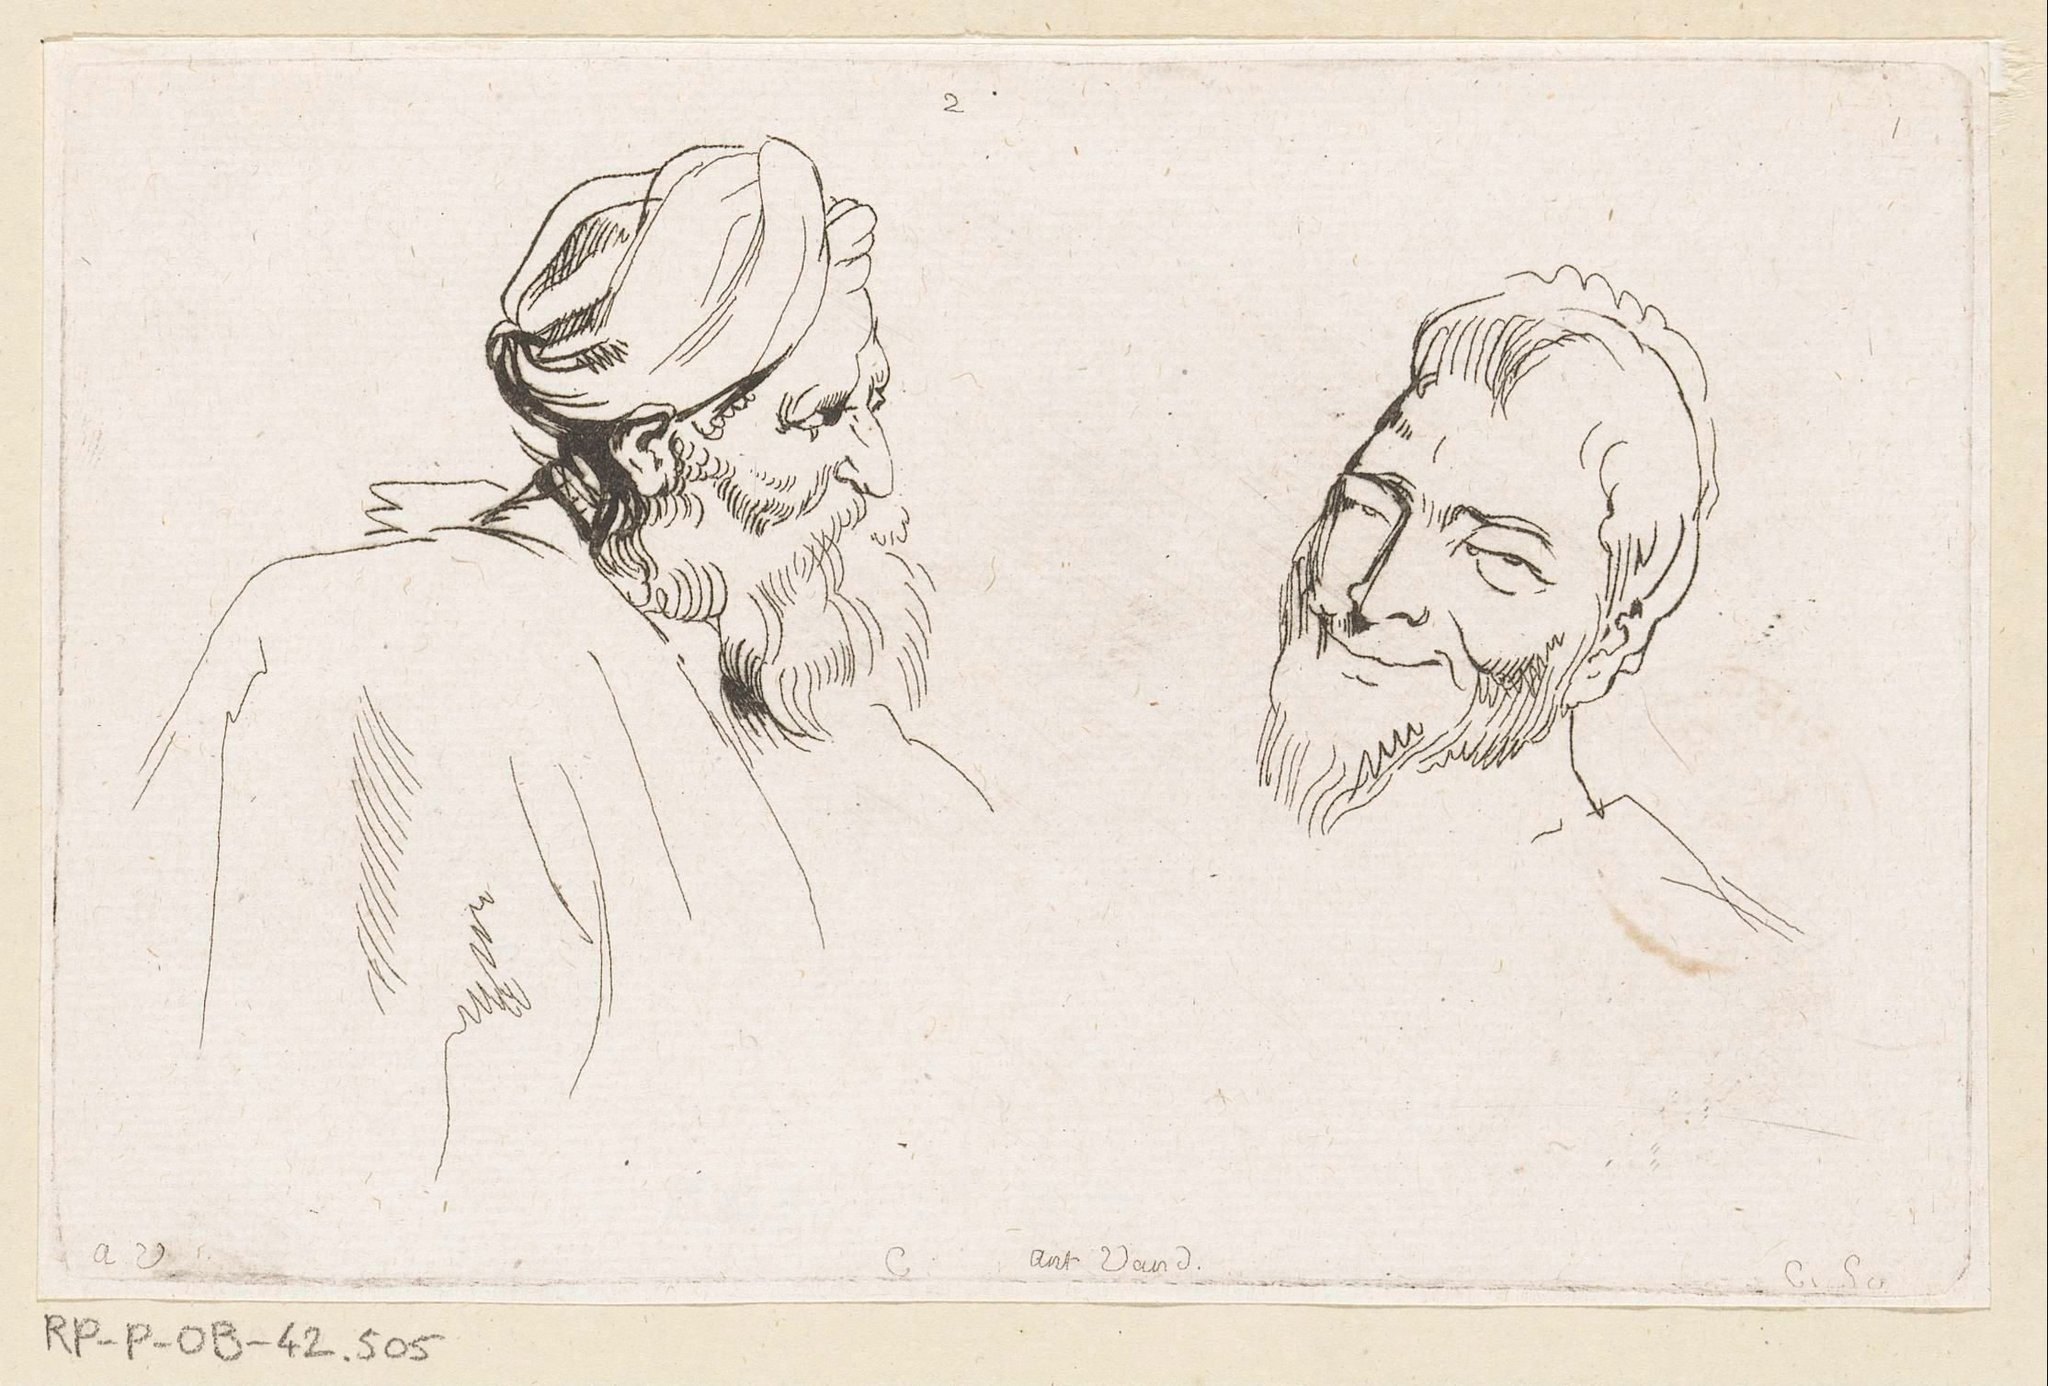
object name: print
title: Twee hoofden van mannen met baard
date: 1735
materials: paper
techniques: etching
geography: france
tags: head (human), adult man, old man, head-gear: turban, beard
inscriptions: collector's mark: Lugt 240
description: Prent uit een serie van 31 prenten naar getekende hoofden door Van Dyck, plus een titelprent naar Bouchardon, getiteld: "Recueil de Testes d'Antoine Van Dyck tirées du Cabinet de M. Crozat et gravées par M. le C. de C.".